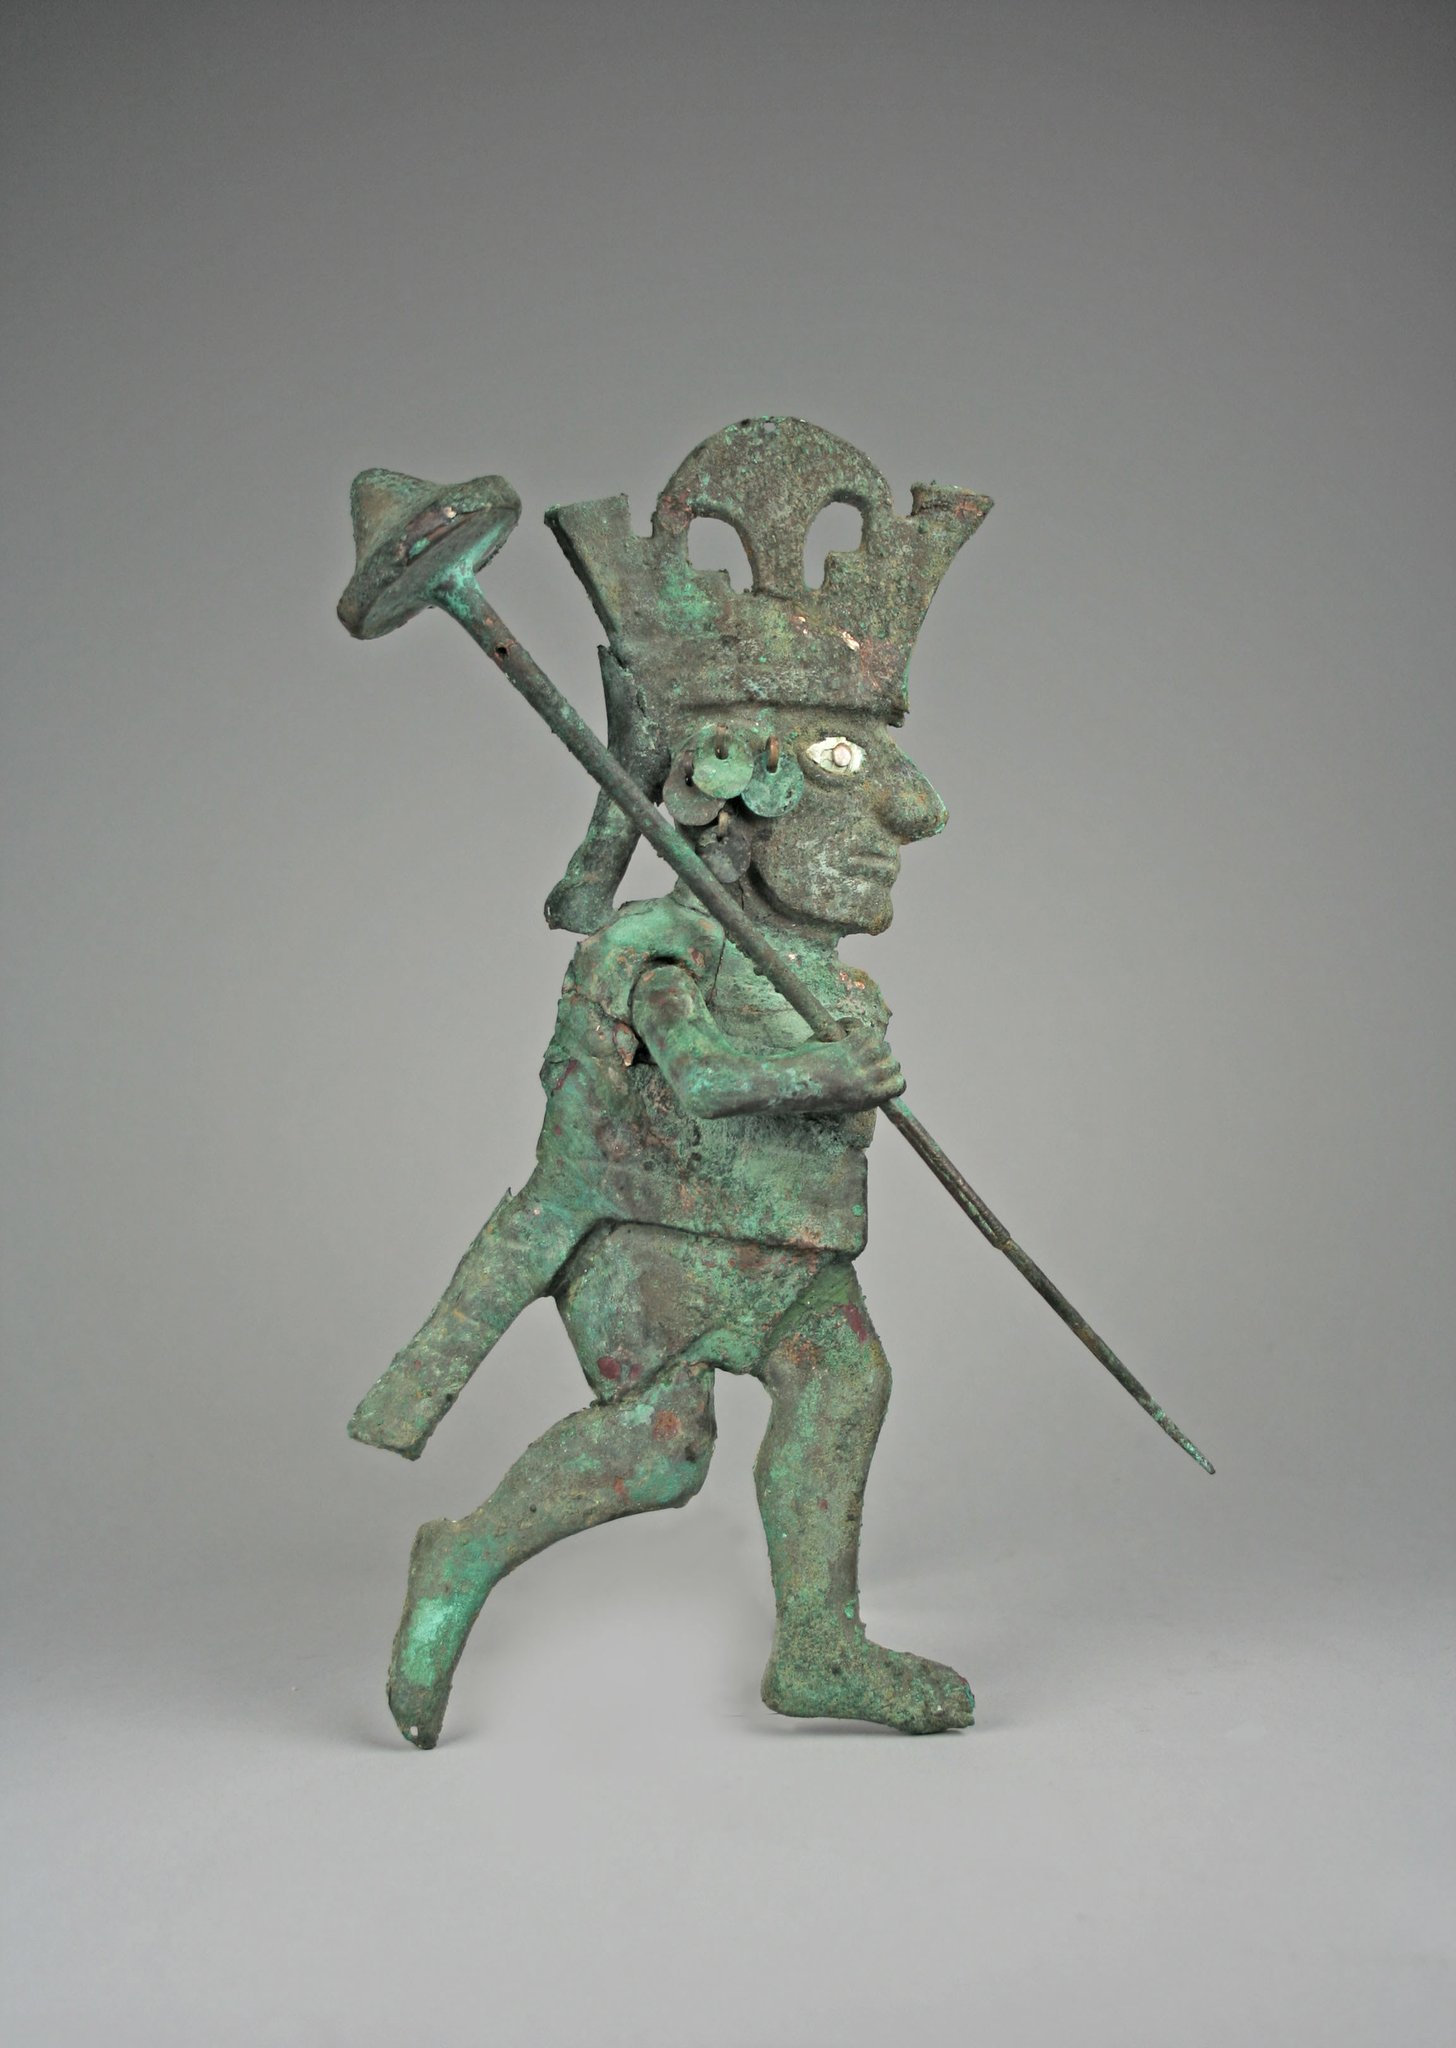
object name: ornament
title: Profile Warrior Ornament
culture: moche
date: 501-700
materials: shell, metal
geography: peru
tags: weapons,men,profiles